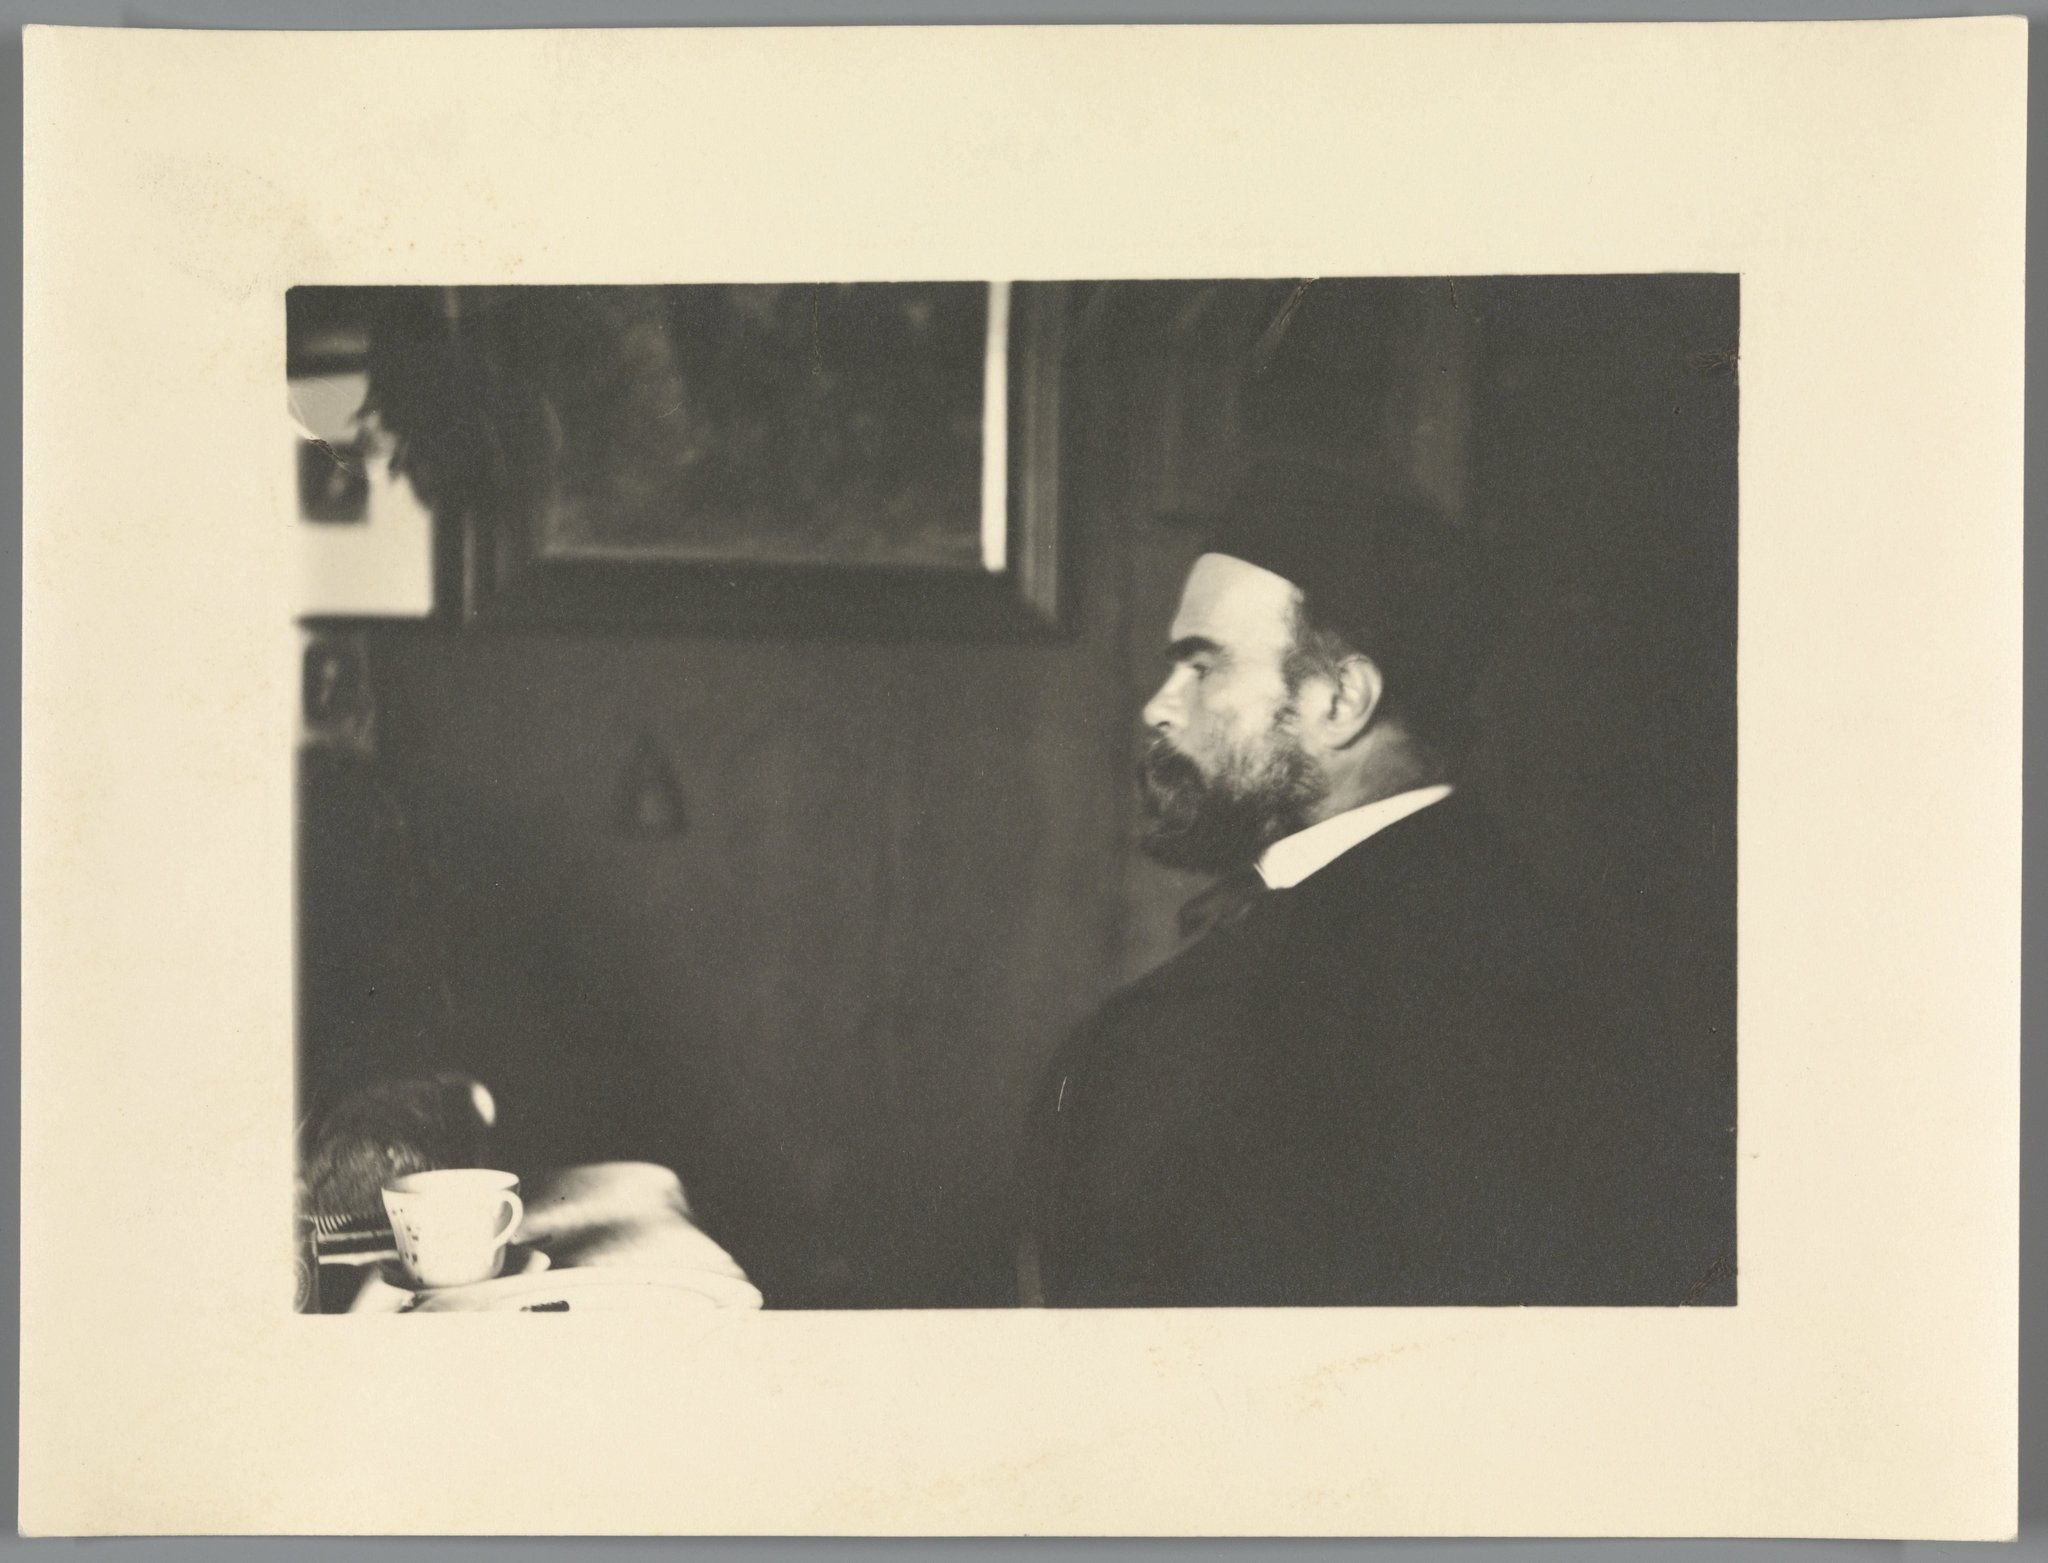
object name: photograph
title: Reproductie naar een foto van Willem Witsen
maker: Anonymous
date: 1860-1915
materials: paper, photographic support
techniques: gelatin silver print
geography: netherlands